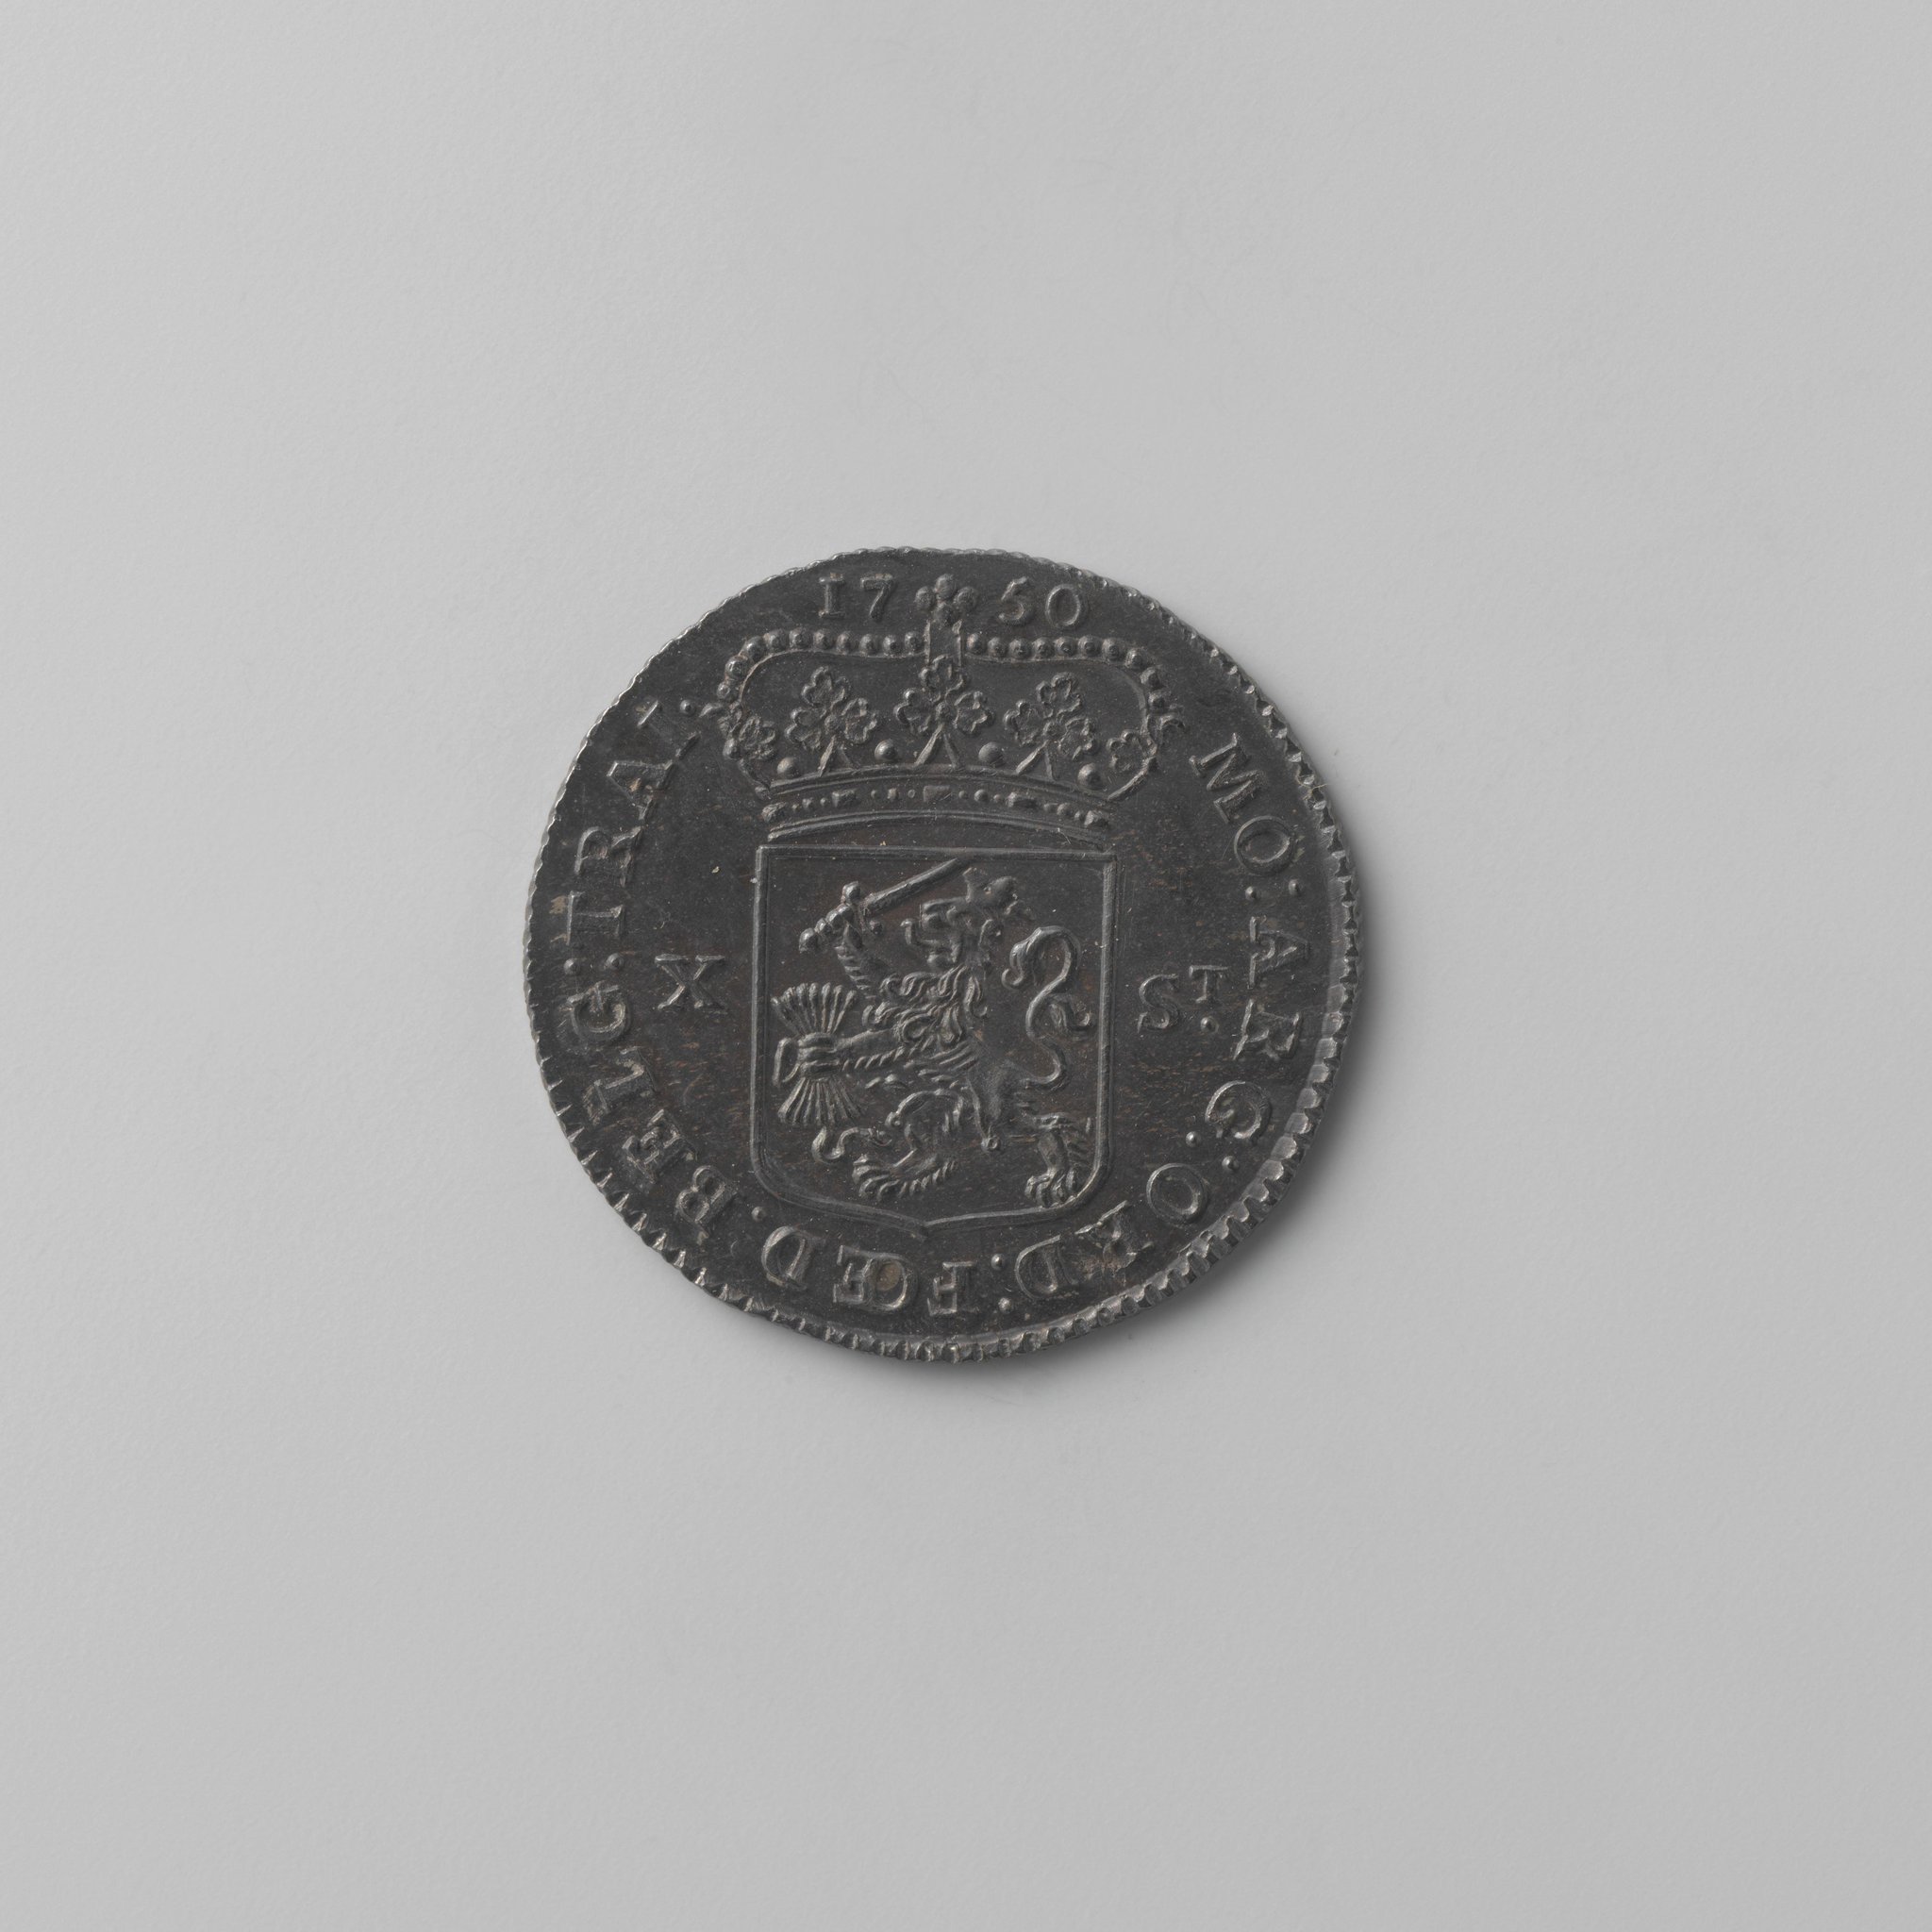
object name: coin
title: Utrechtse halve gulden, 1750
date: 1750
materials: silver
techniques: striking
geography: utrecht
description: Zilveren munt. Voorzijde: tussen waarde-aanduiding X St gekroond generaliteitswapenschild. Jaartal boven kroon. Keerzijde: Nederlandse maagd met vrijheidshoed en speer, leunend op een bijbel op een altaar. Kabelrand.